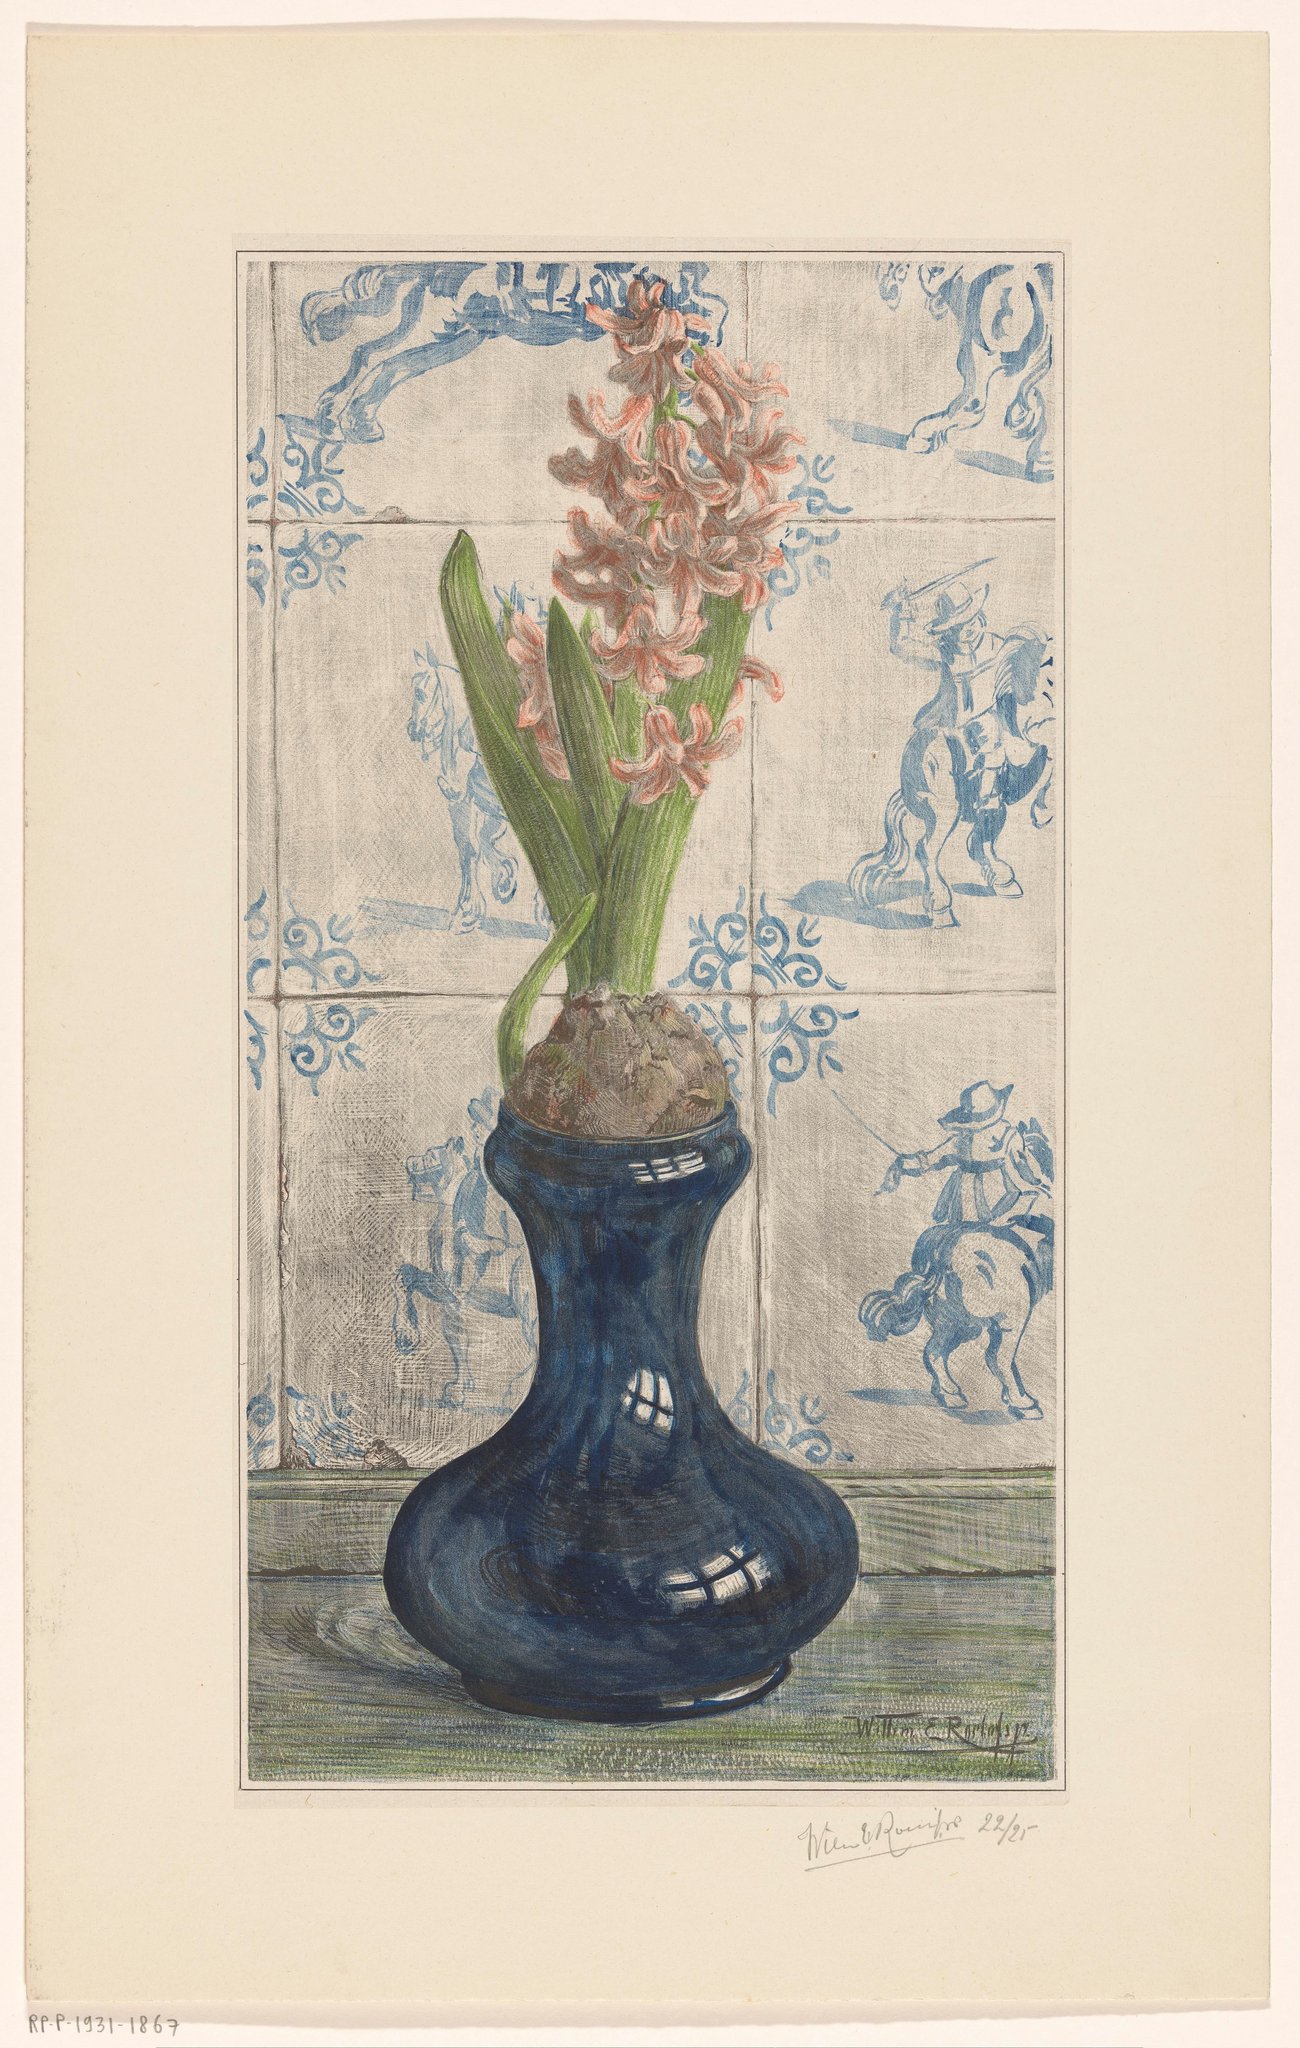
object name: print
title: Hyacint op een glazen vaas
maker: willem roelofs (ii)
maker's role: draughtsman, painter, print maker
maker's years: 1874-1940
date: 1884-1931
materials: paper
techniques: lithograph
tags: riding a horse, ass, or mule; rider, horseman, flowers, container of glass: bottle, jar, vase, tiles, bricks ~ building material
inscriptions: number: ‘10’, collector's mark: Lugt 2228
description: Op de achtergrond tegels met gewapende ruiters te paard.